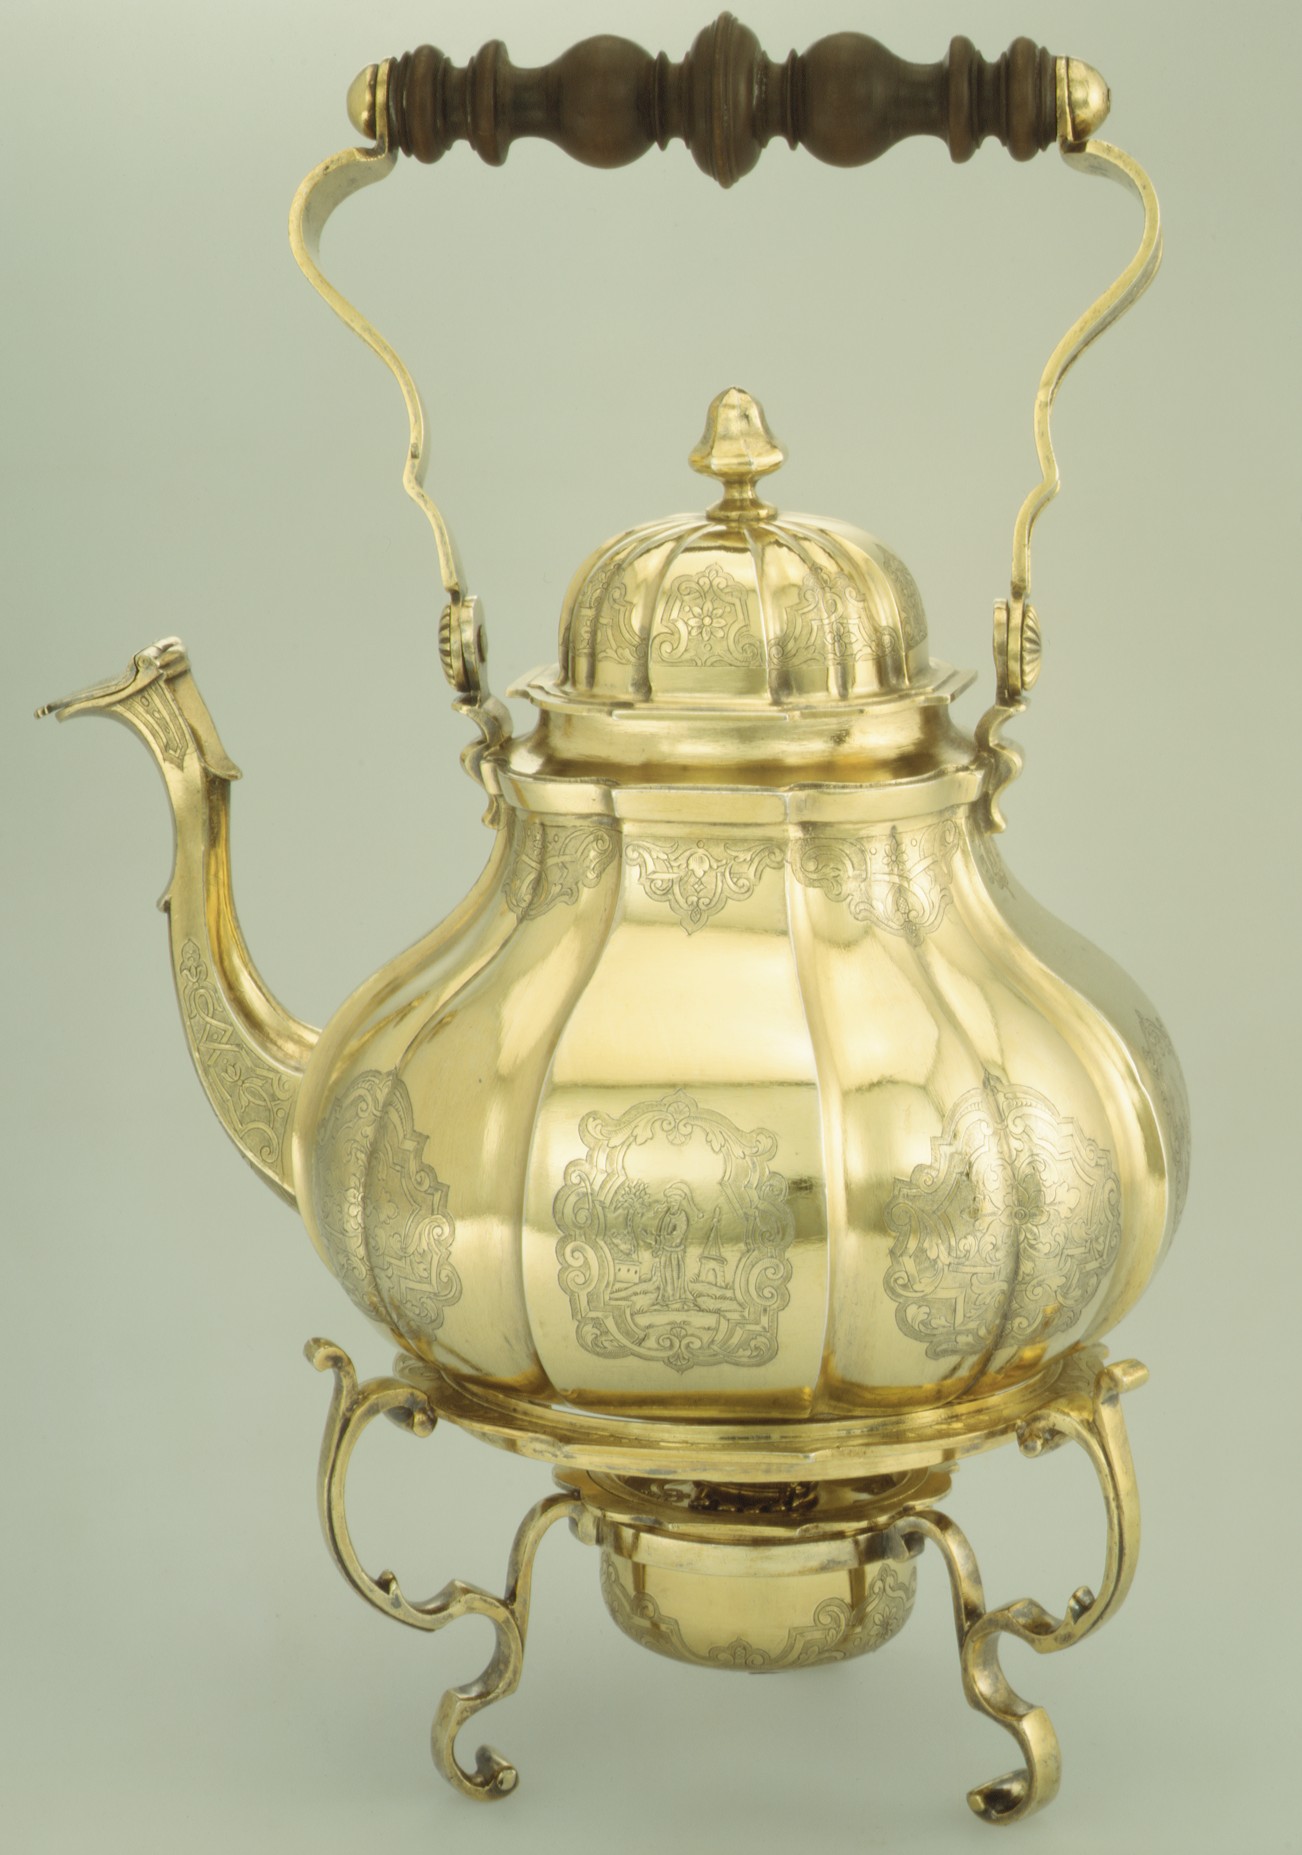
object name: kettle and lamp stand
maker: esaias busch iii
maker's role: maker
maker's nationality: german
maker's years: 1676-1759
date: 1718-1720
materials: silver gilt